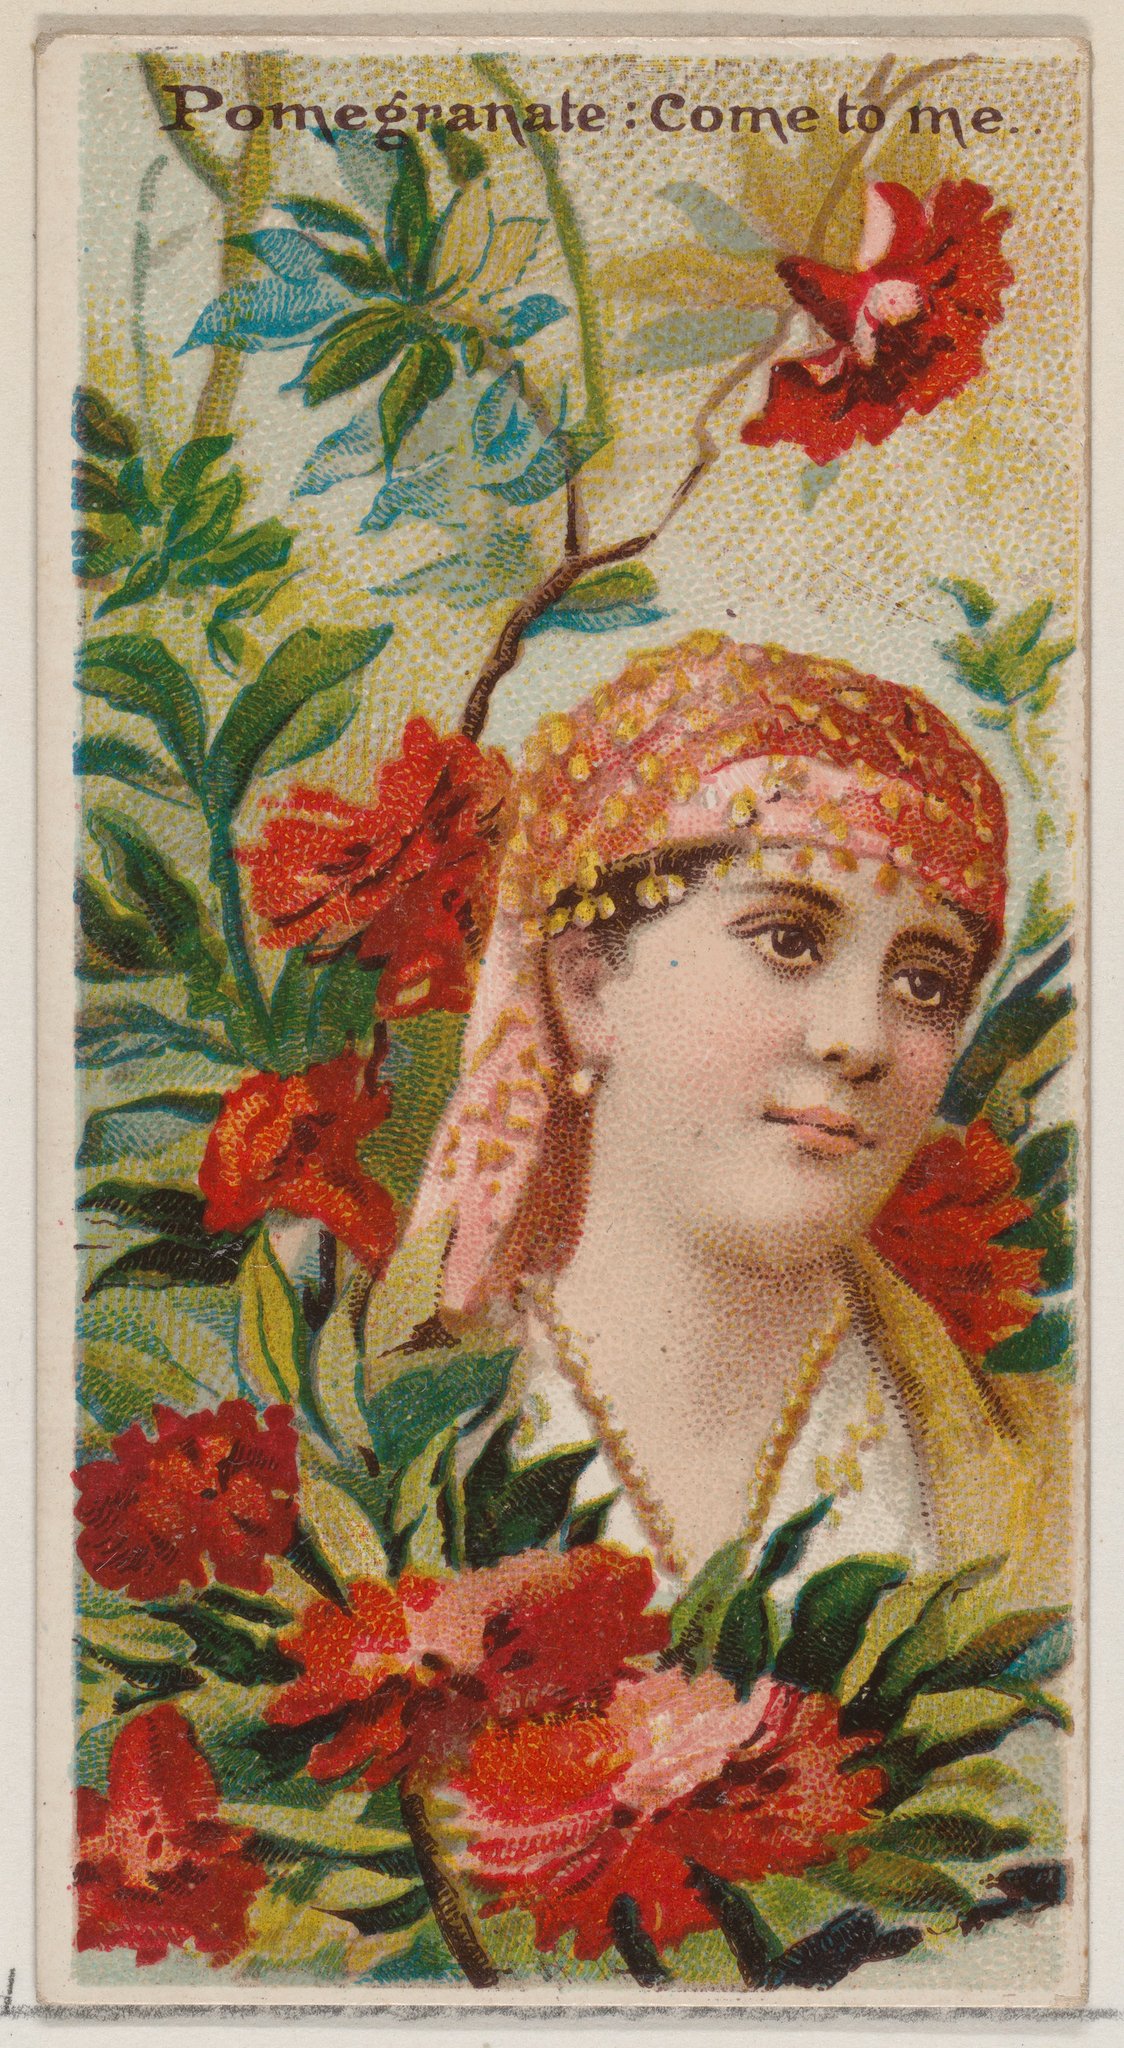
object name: print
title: Pomegranate: Come to Me, from the series Floral Beauties and Language of Flowers (N75) for Duke brand cigarettes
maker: american tobacco company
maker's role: publisher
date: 1892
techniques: color lithograph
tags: women,flowers